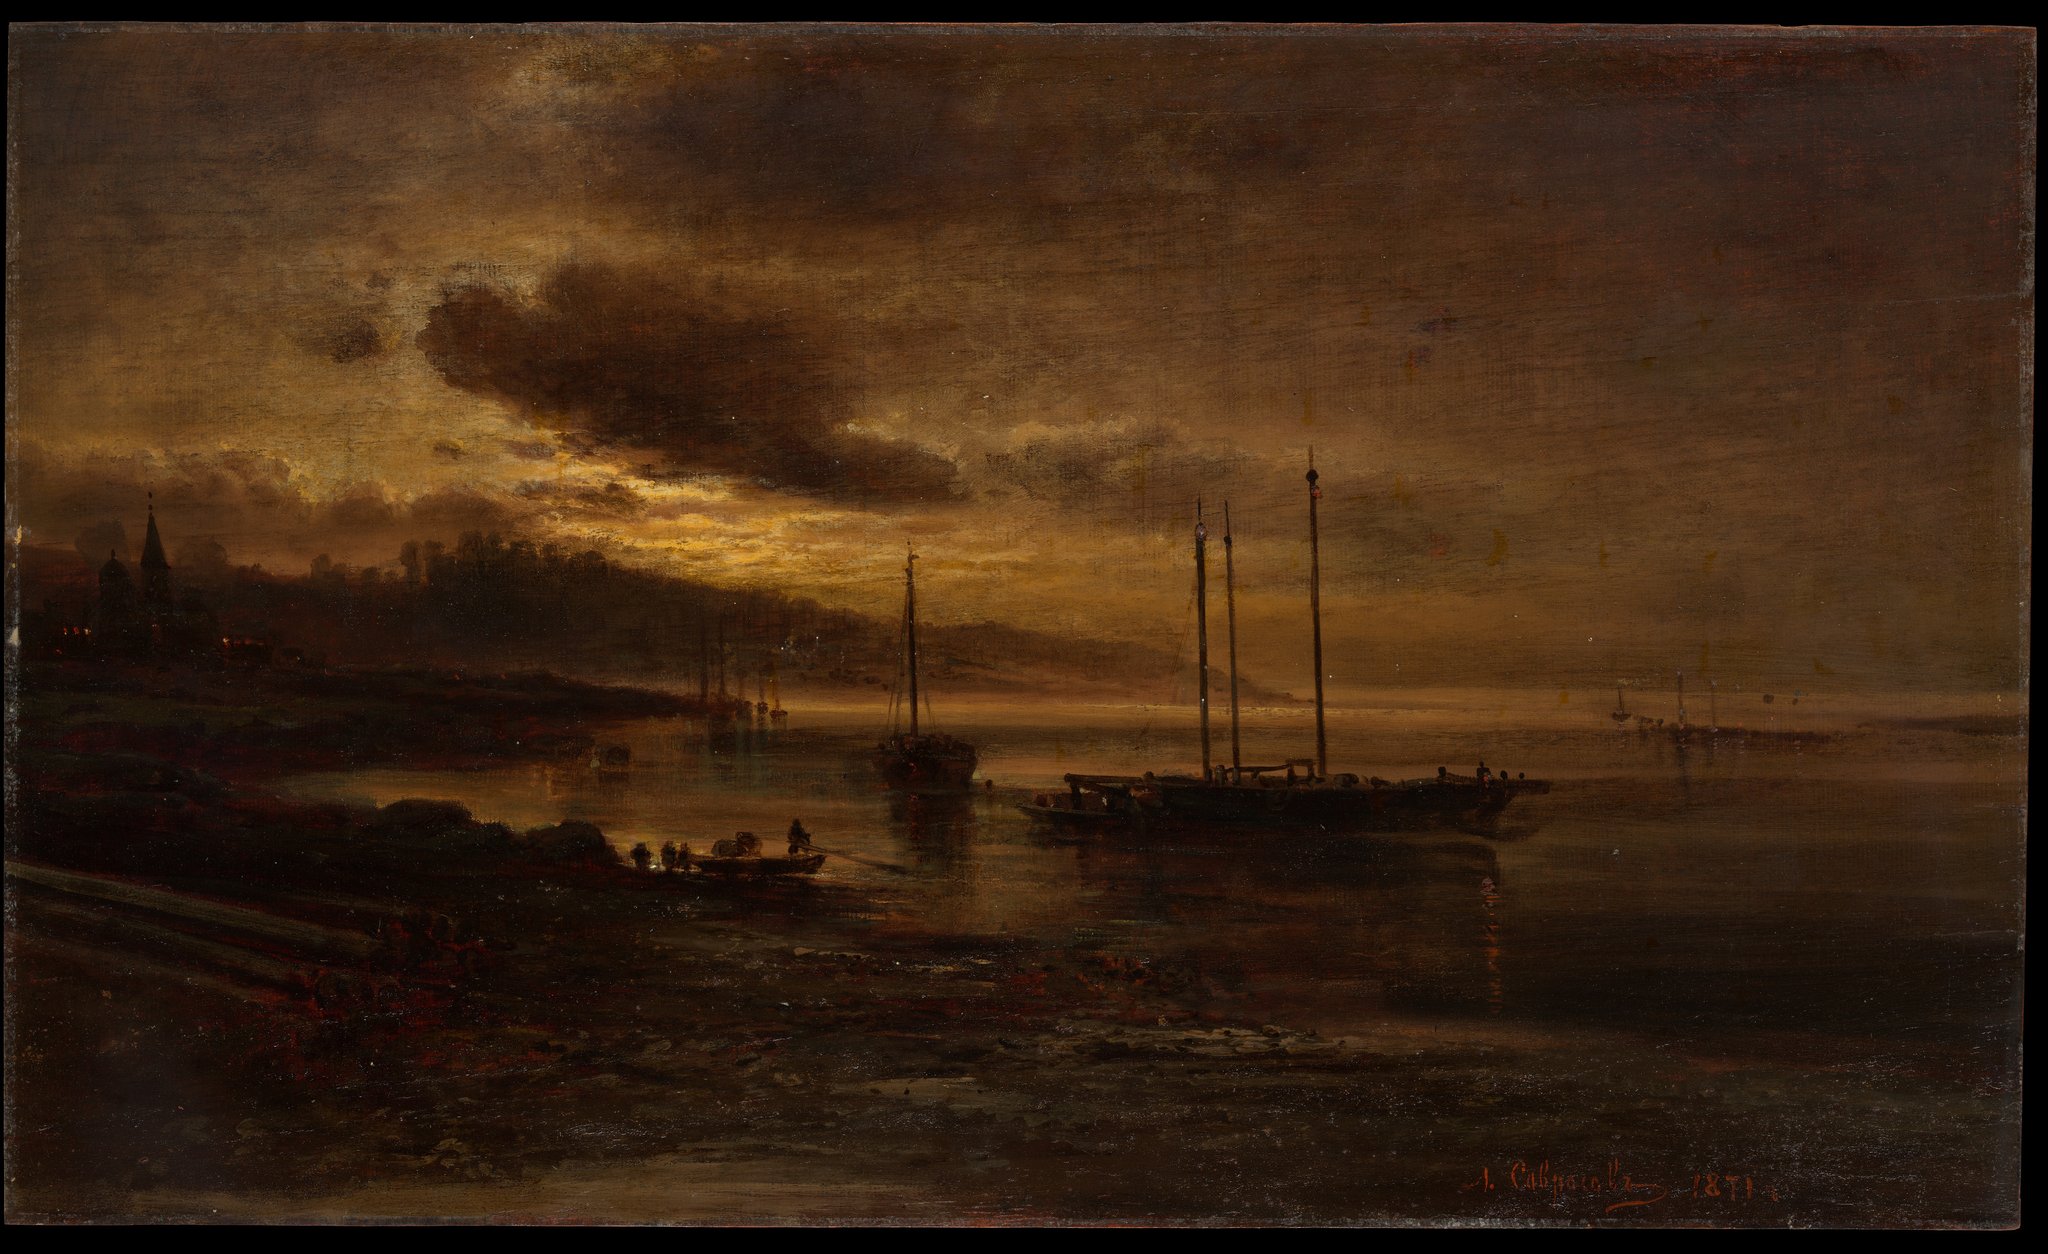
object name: painting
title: Night Scene on the Volga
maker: alexei kondratievich savrasov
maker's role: artist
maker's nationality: russian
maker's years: 1830-1897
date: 1871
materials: oil, wood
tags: rivers,night,boats